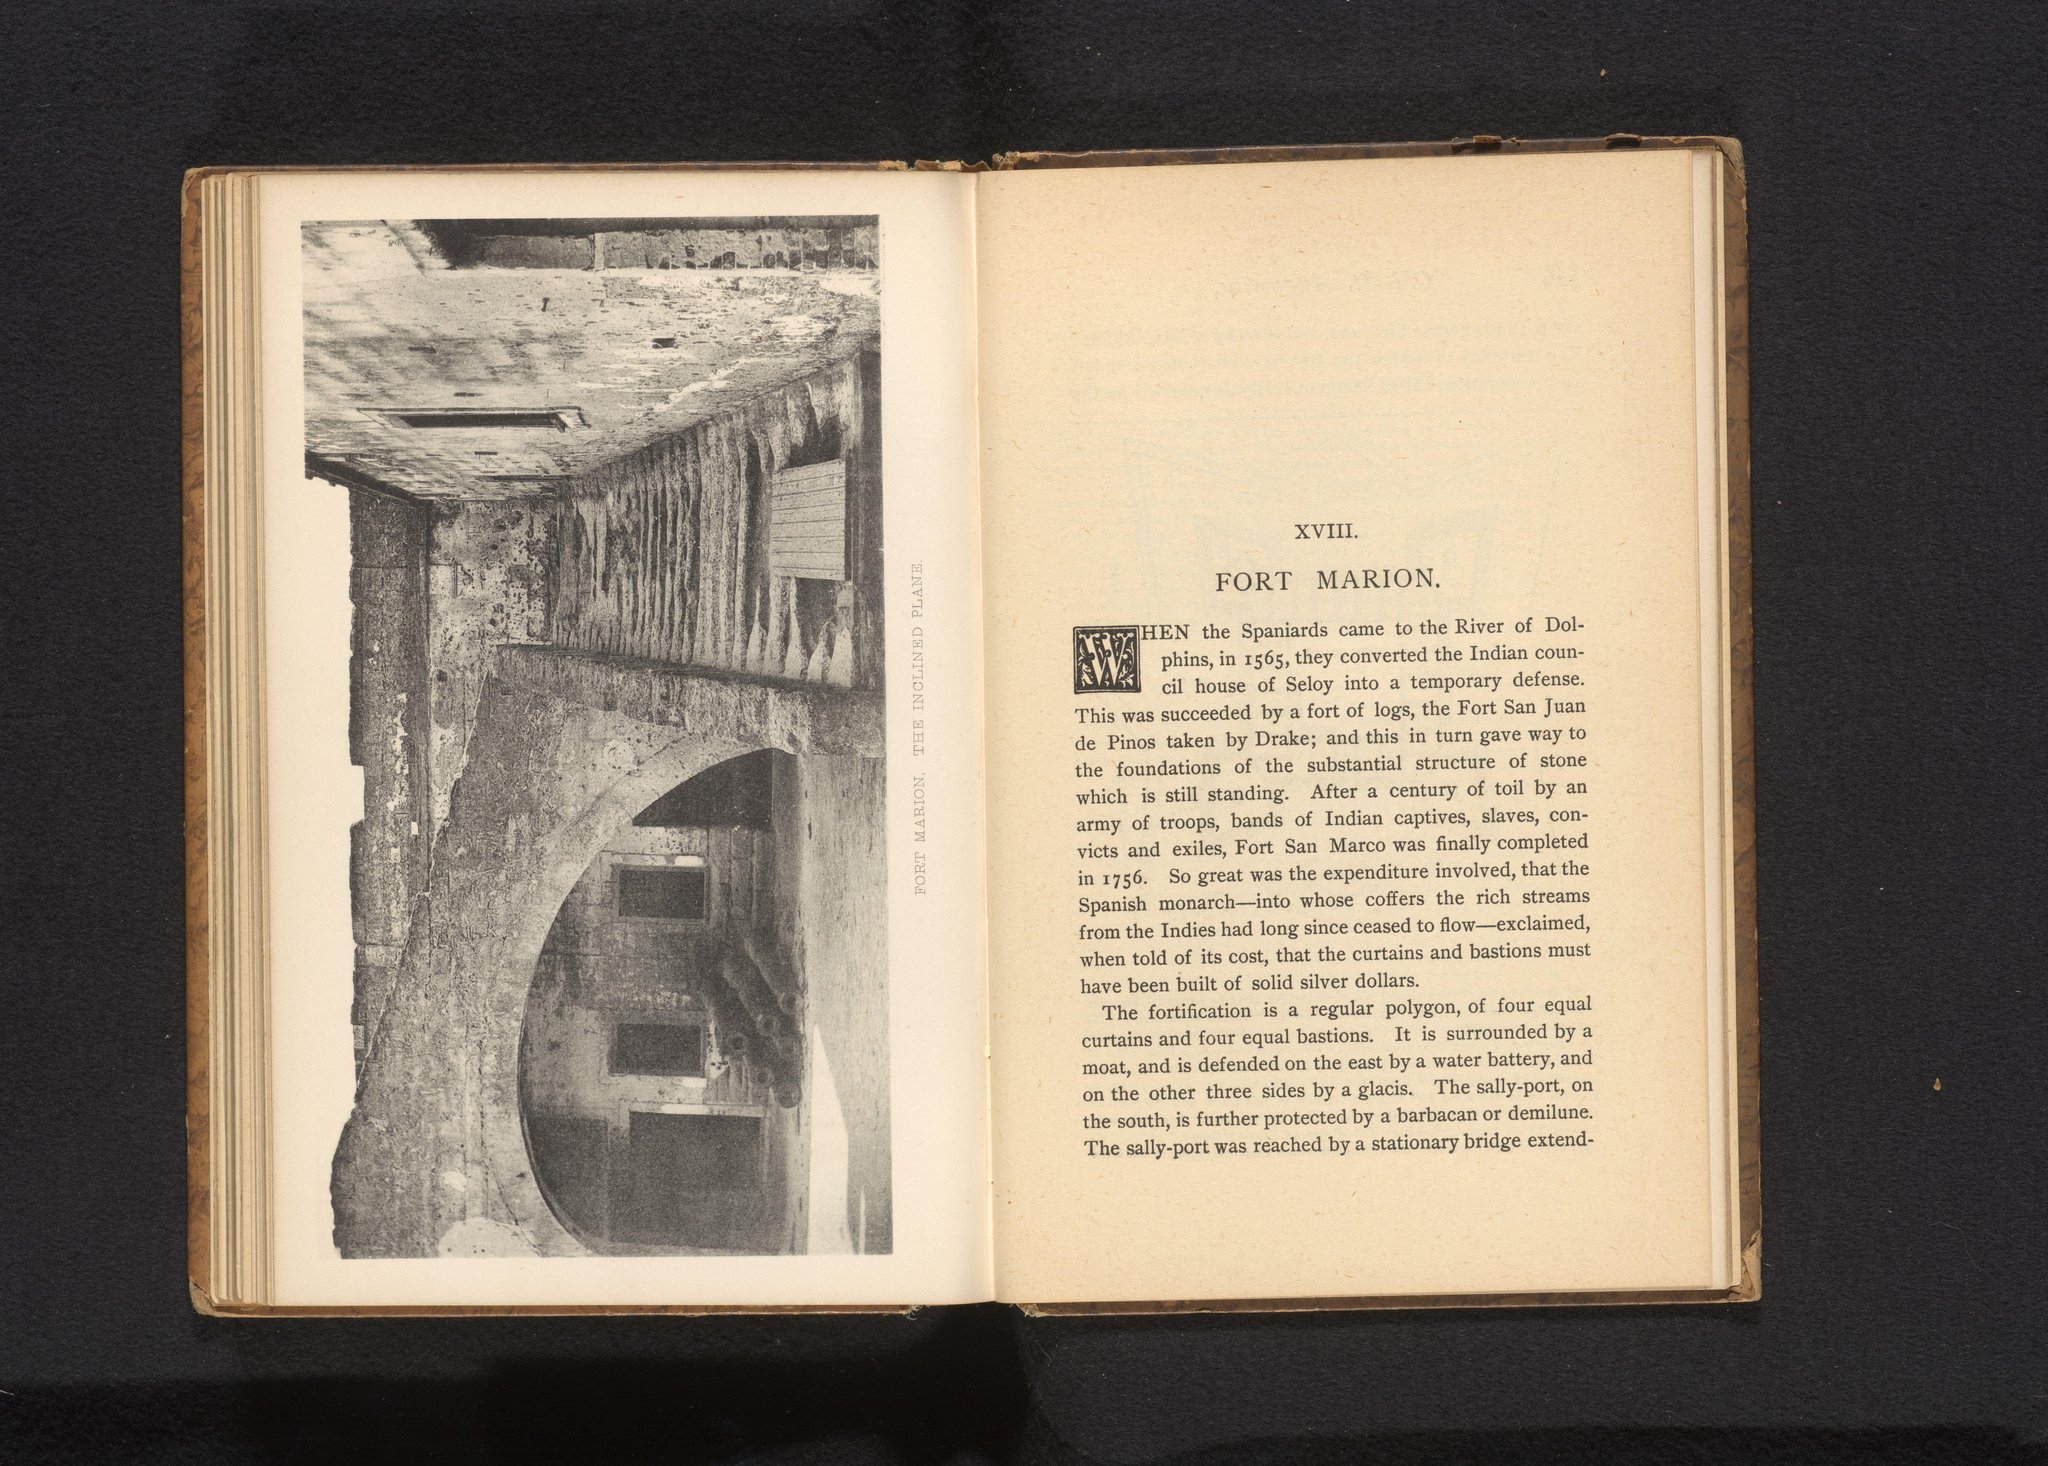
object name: page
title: Fort Marion, the inclined plane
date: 1883-1888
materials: paper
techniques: photograph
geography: saint augustine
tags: fortress